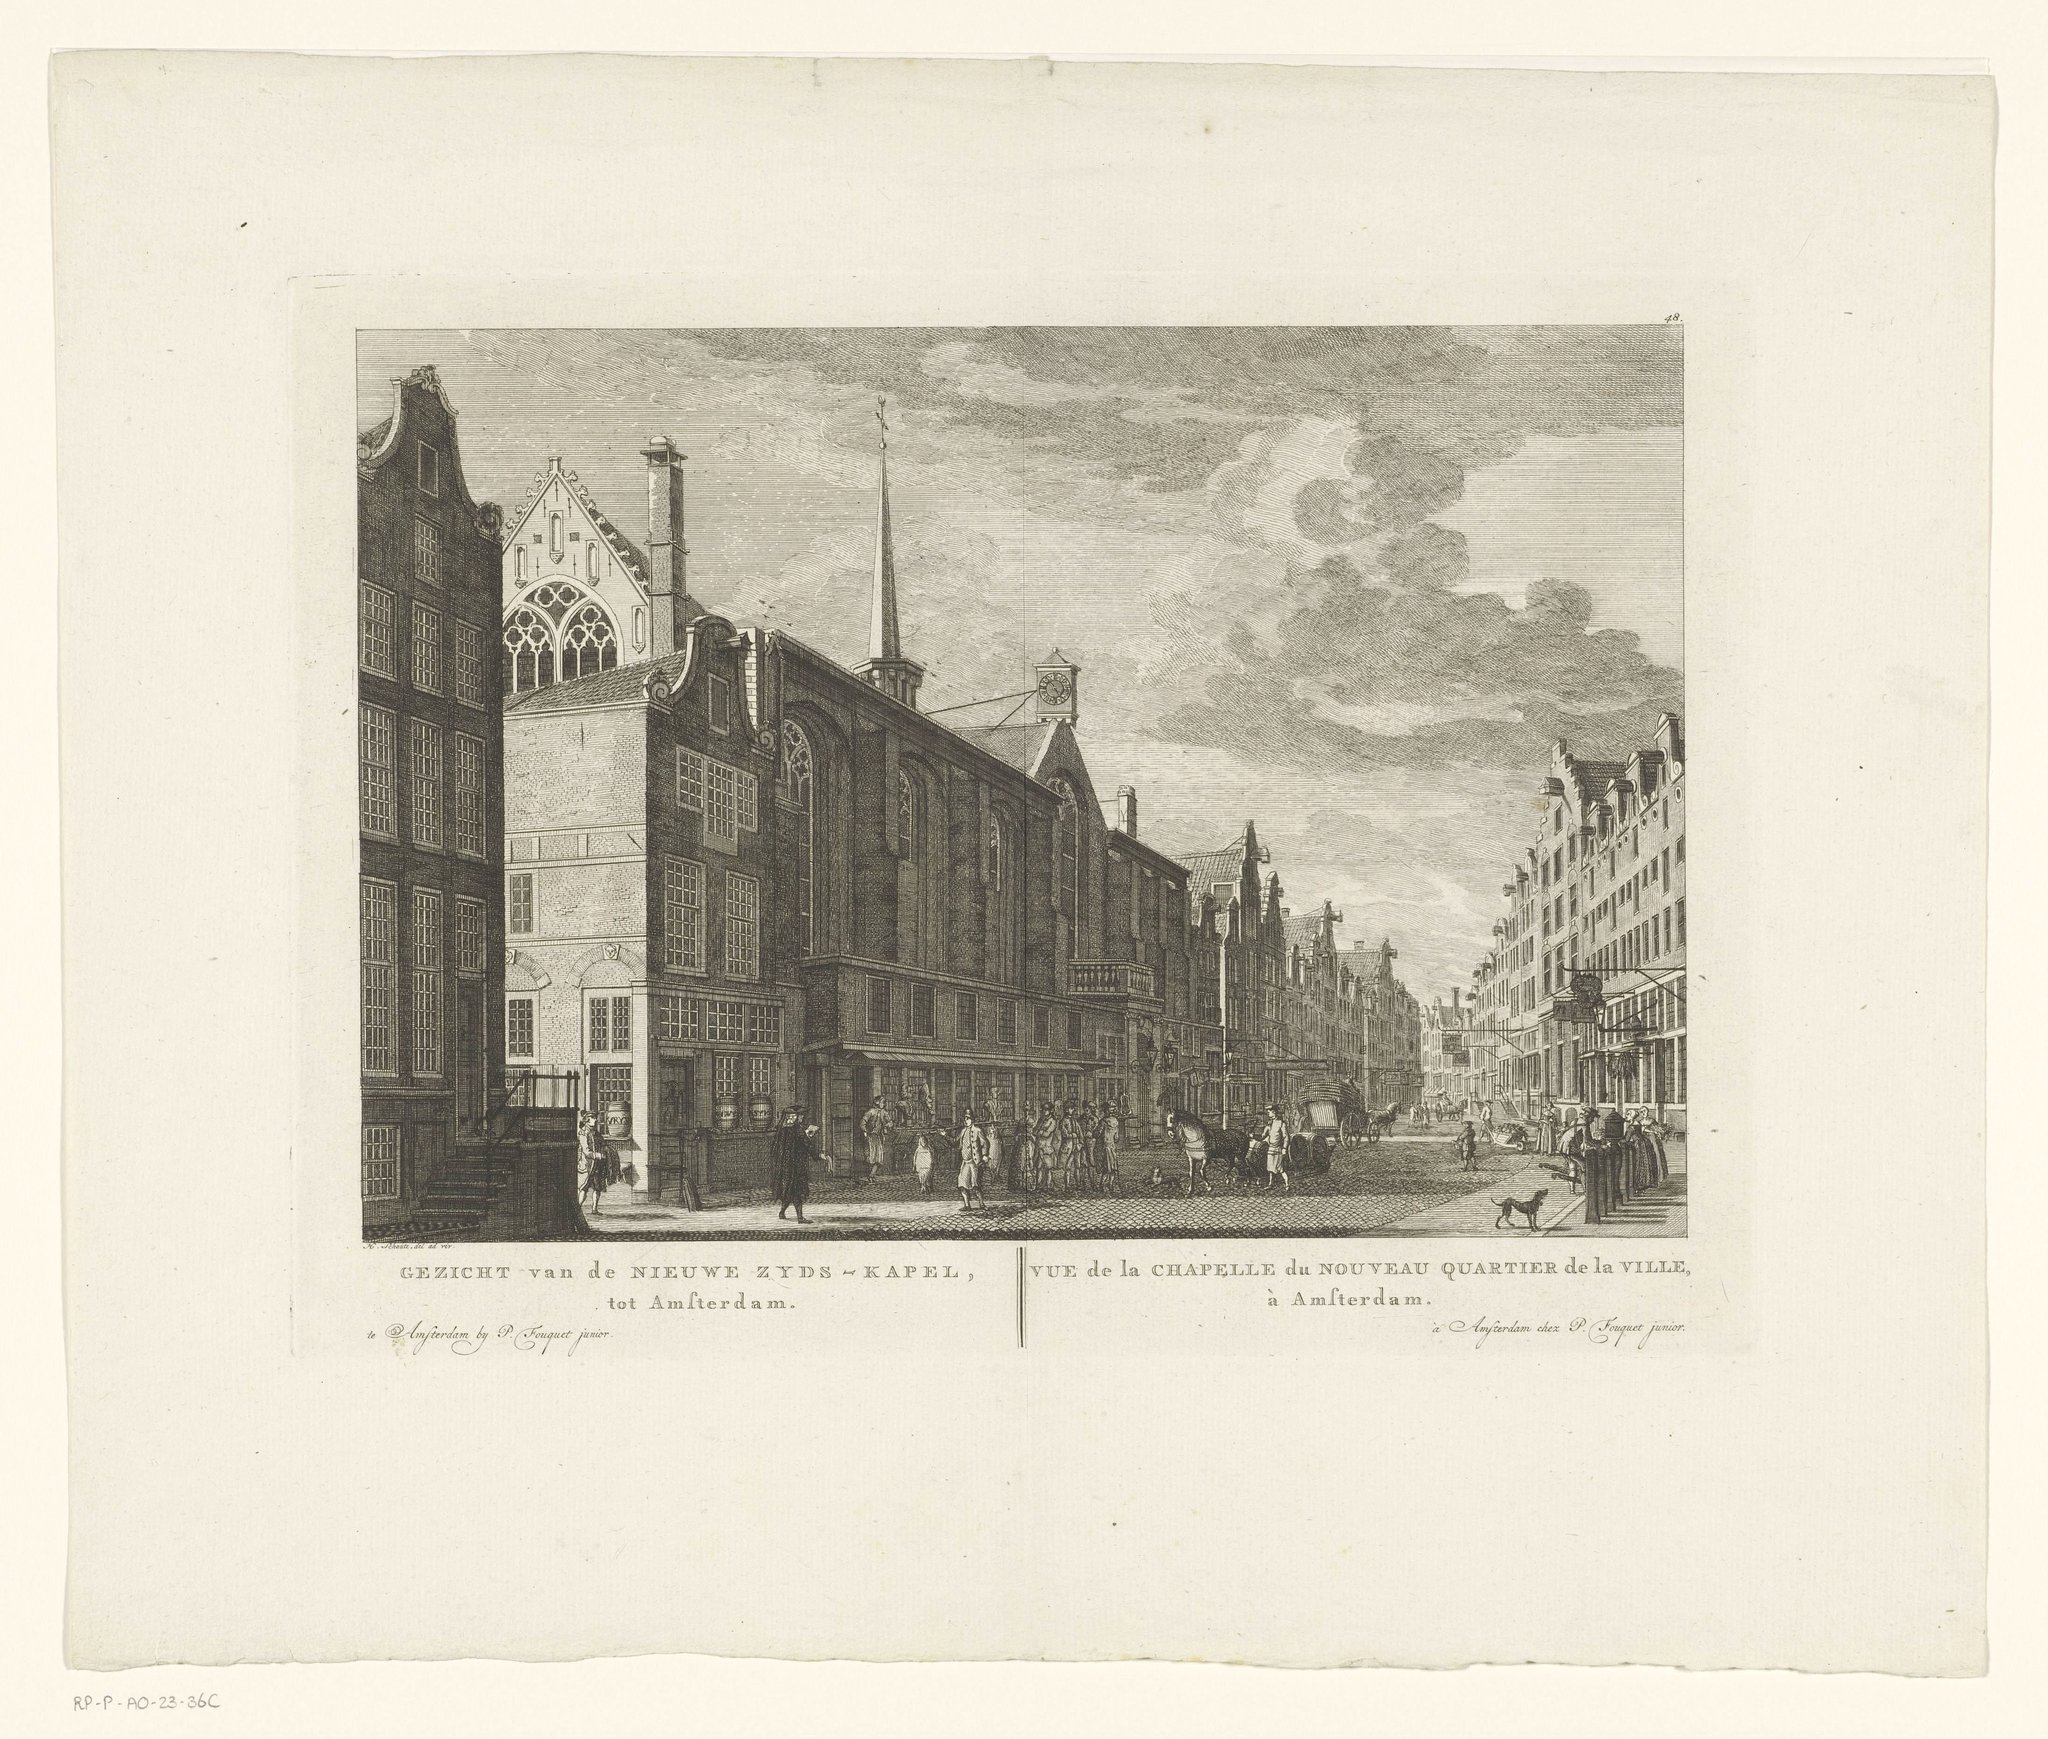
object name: print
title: Gezicht van de Nieuwe Zyds-Kapel, tot Amsterdam / Vue de la Chapelle du Nouveau Quartier de la Ville, à Amsterdam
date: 1770-1783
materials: paper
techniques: engraving, etching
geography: amsterdam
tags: church (exterior) - qq - small church, chapel, street (+ city(-scape) with figures, staffage)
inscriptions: collector's mark: Lugt 2228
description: Deze prent is ook gebruikt in de zogenaamde Atlas van Fouquet.* Pierre Fouquet gaf vanaf 1760 stadsgezichten van Amsterdam - naar tekeningen van verschillende kunstenaars, gemaakt door verschillende prentmakers - uit. Deze prenten werden aanvankelijk los of in series verkocht. Zoals toen gebruikelijk kon de koper de prenten zelf laten inbinden. Hiertoe gaf Fouquet tussen 1778 en 1783 een titelblad, plattegrond en inhoudsopgave van de tot dusver 100 uitgegeven prenten uit (1). Gezien de inhoud afhankelijk was van wat de koper had verzameld verschilt de inhoud van de verschillende bewaarde Fouquetatlassen onder deze titel sterk. Ook zijn er exemplaren bekend waar tevens andere prenten aan zijn toegevoegd. Omdat er behoefte bleek aan uitleg bij de platen werd in 1783 een nieuwe versie van de atlas uitgegeven, aangevuld met tekst en twee prenten. De aangegeven volgorde veranderde maar de platen van de al eerder uitgegeven prenten bleven ongewijzigd. Deze uitgave werd in opdracht van Fouquet gedrukt bij Daniël Jean Changuion en Petrus den Hengst (2). Een tiental platen werd bijgewerkt en verscheen, met nieuw impressum, in het vervolg van Wagenaars geschiedenis van Amsterdam, uitgeven door Petrus Conradi en Folkert van der Plaats (3). Een aantal jaar na het overlijden van Fouquet kwam Evert Maaskamp met een nieuwe uitgave van de atlas, met verbeterde tekst en toevoeging van twee prenten. Op alle platen verwijderde hij het oude en liet hij zijn eigen impressum zetten (4). De huidige staat van de prent komt voor in exemplaren van de onder (1) en (2) genoemde werken. * Onder de Atlas van Fouquet of Fouquetatlas verstaan we de hieronder vermelde publicaties (1), (2) en (4). (1). Afbeeldingen van de wyd-vermaarde koopstad Amsterdam benevens des zelvs voornaamste gebouwen en gezigten alle naar het leeven getekend / Receuil des edifices les plus considerables et des plus belles vues, de la fameuse ville d'Amsterdam, dessinées d'après nature. Amsterdam: Pierre Fouquet, 1778-1783. (2). Nieuwe atlas, van de voornaamste gebouwen en gezigten der stad Amsterdam, met derzelver beknopte beschryvingen. 2 delen. Amsterdam: Daniël Jean Changuion en Petrus den Hengst [in opdracht van Pierre Fouquet], 1783. (3). Stijl, Simon. Amsterdam, in zyne geschiedenissen, voorregten, koophandel, gebouwen, kerkenstaat, schoolen, schutterye, gilden en regeeringe, beschreeven. Om te dienen ten vervolge op het werk van Jan Wagenaar (…). 10 delen. Amsterdam en Harlingen: Petrus Conradi en Folkert van der Plaats, 1788-1801. (4). Nieuwe atlas, van de voornaamste gebouwen en gezigten der stad Amsterdam. Met derzelver beknopte beschryvingen. Amsterdam: Evert Maaskamp, 1805. * Het aantal vermelde staten is gebaseerd op het aantal gevonden staten. Mogelijk zijn er meer staten van deze prent.